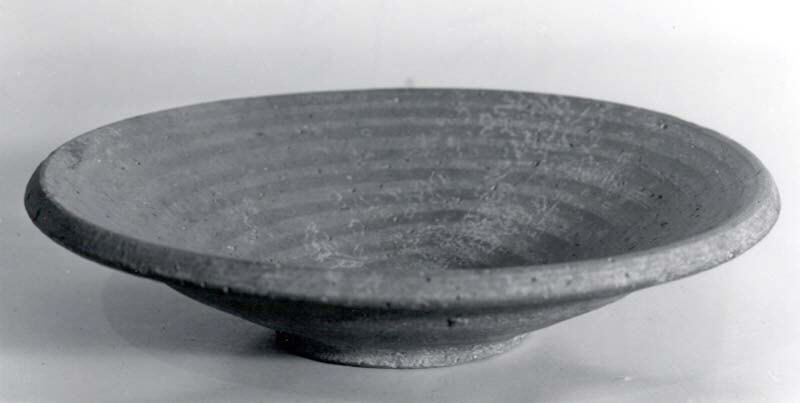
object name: bowl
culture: israelite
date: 734-601 BCE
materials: ceramic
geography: levant